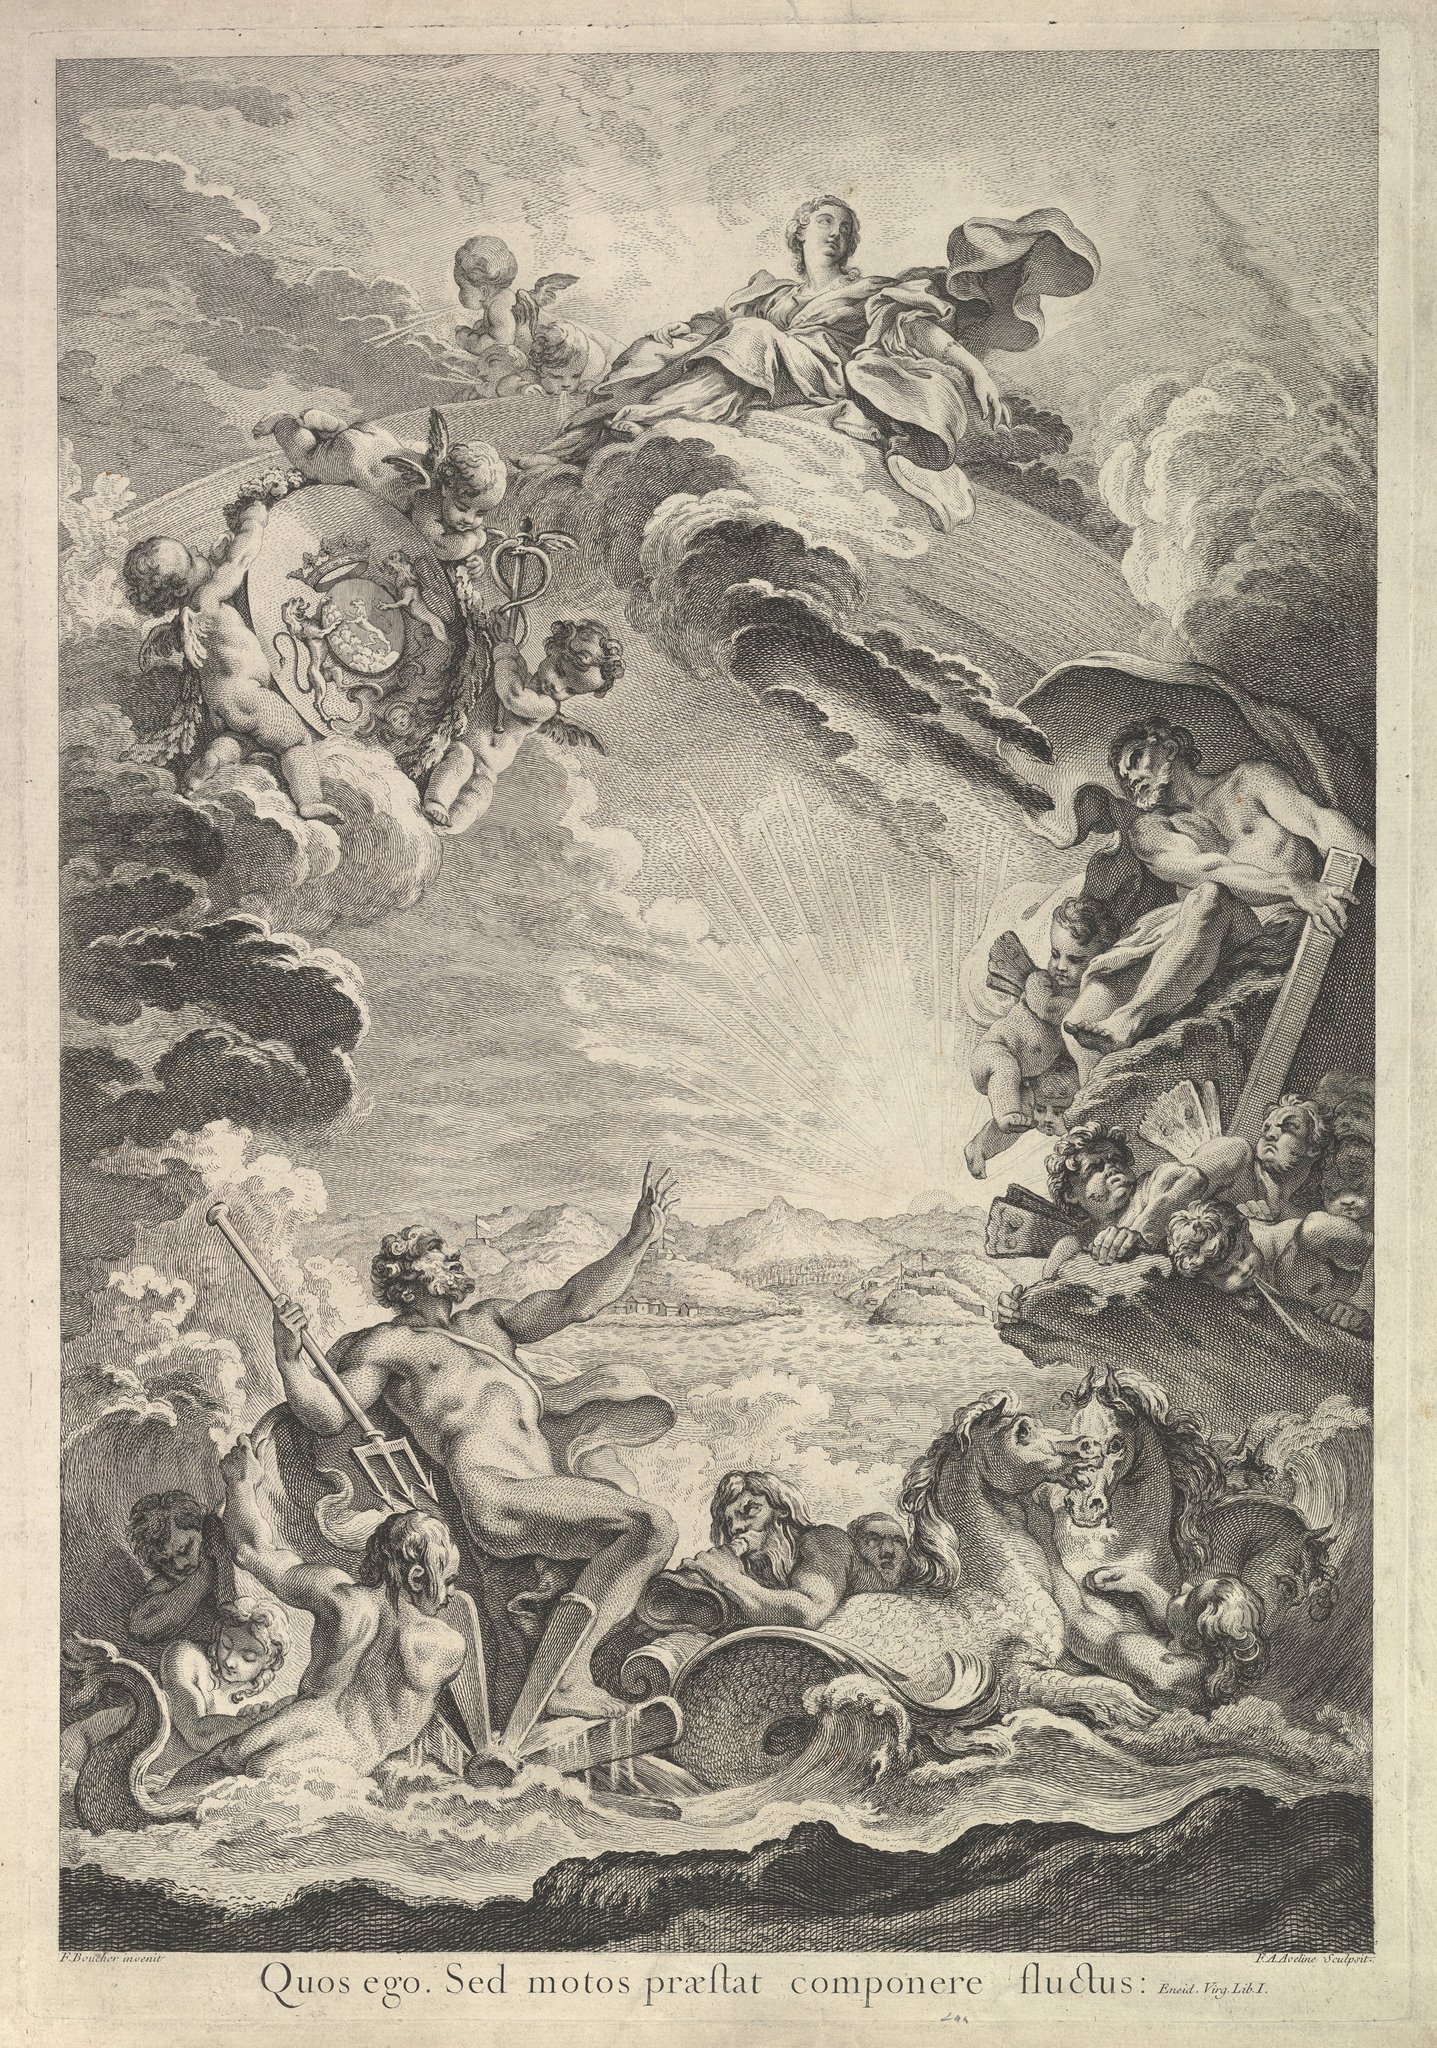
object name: print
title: Neptune apaisant la tempête (Neptune Calming the Storm)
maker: françois antoine aveline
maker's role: artist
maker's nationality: french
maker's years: 1718-1780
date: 1701-1800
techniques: engraving, etching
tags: neptune,storms,coat of arms